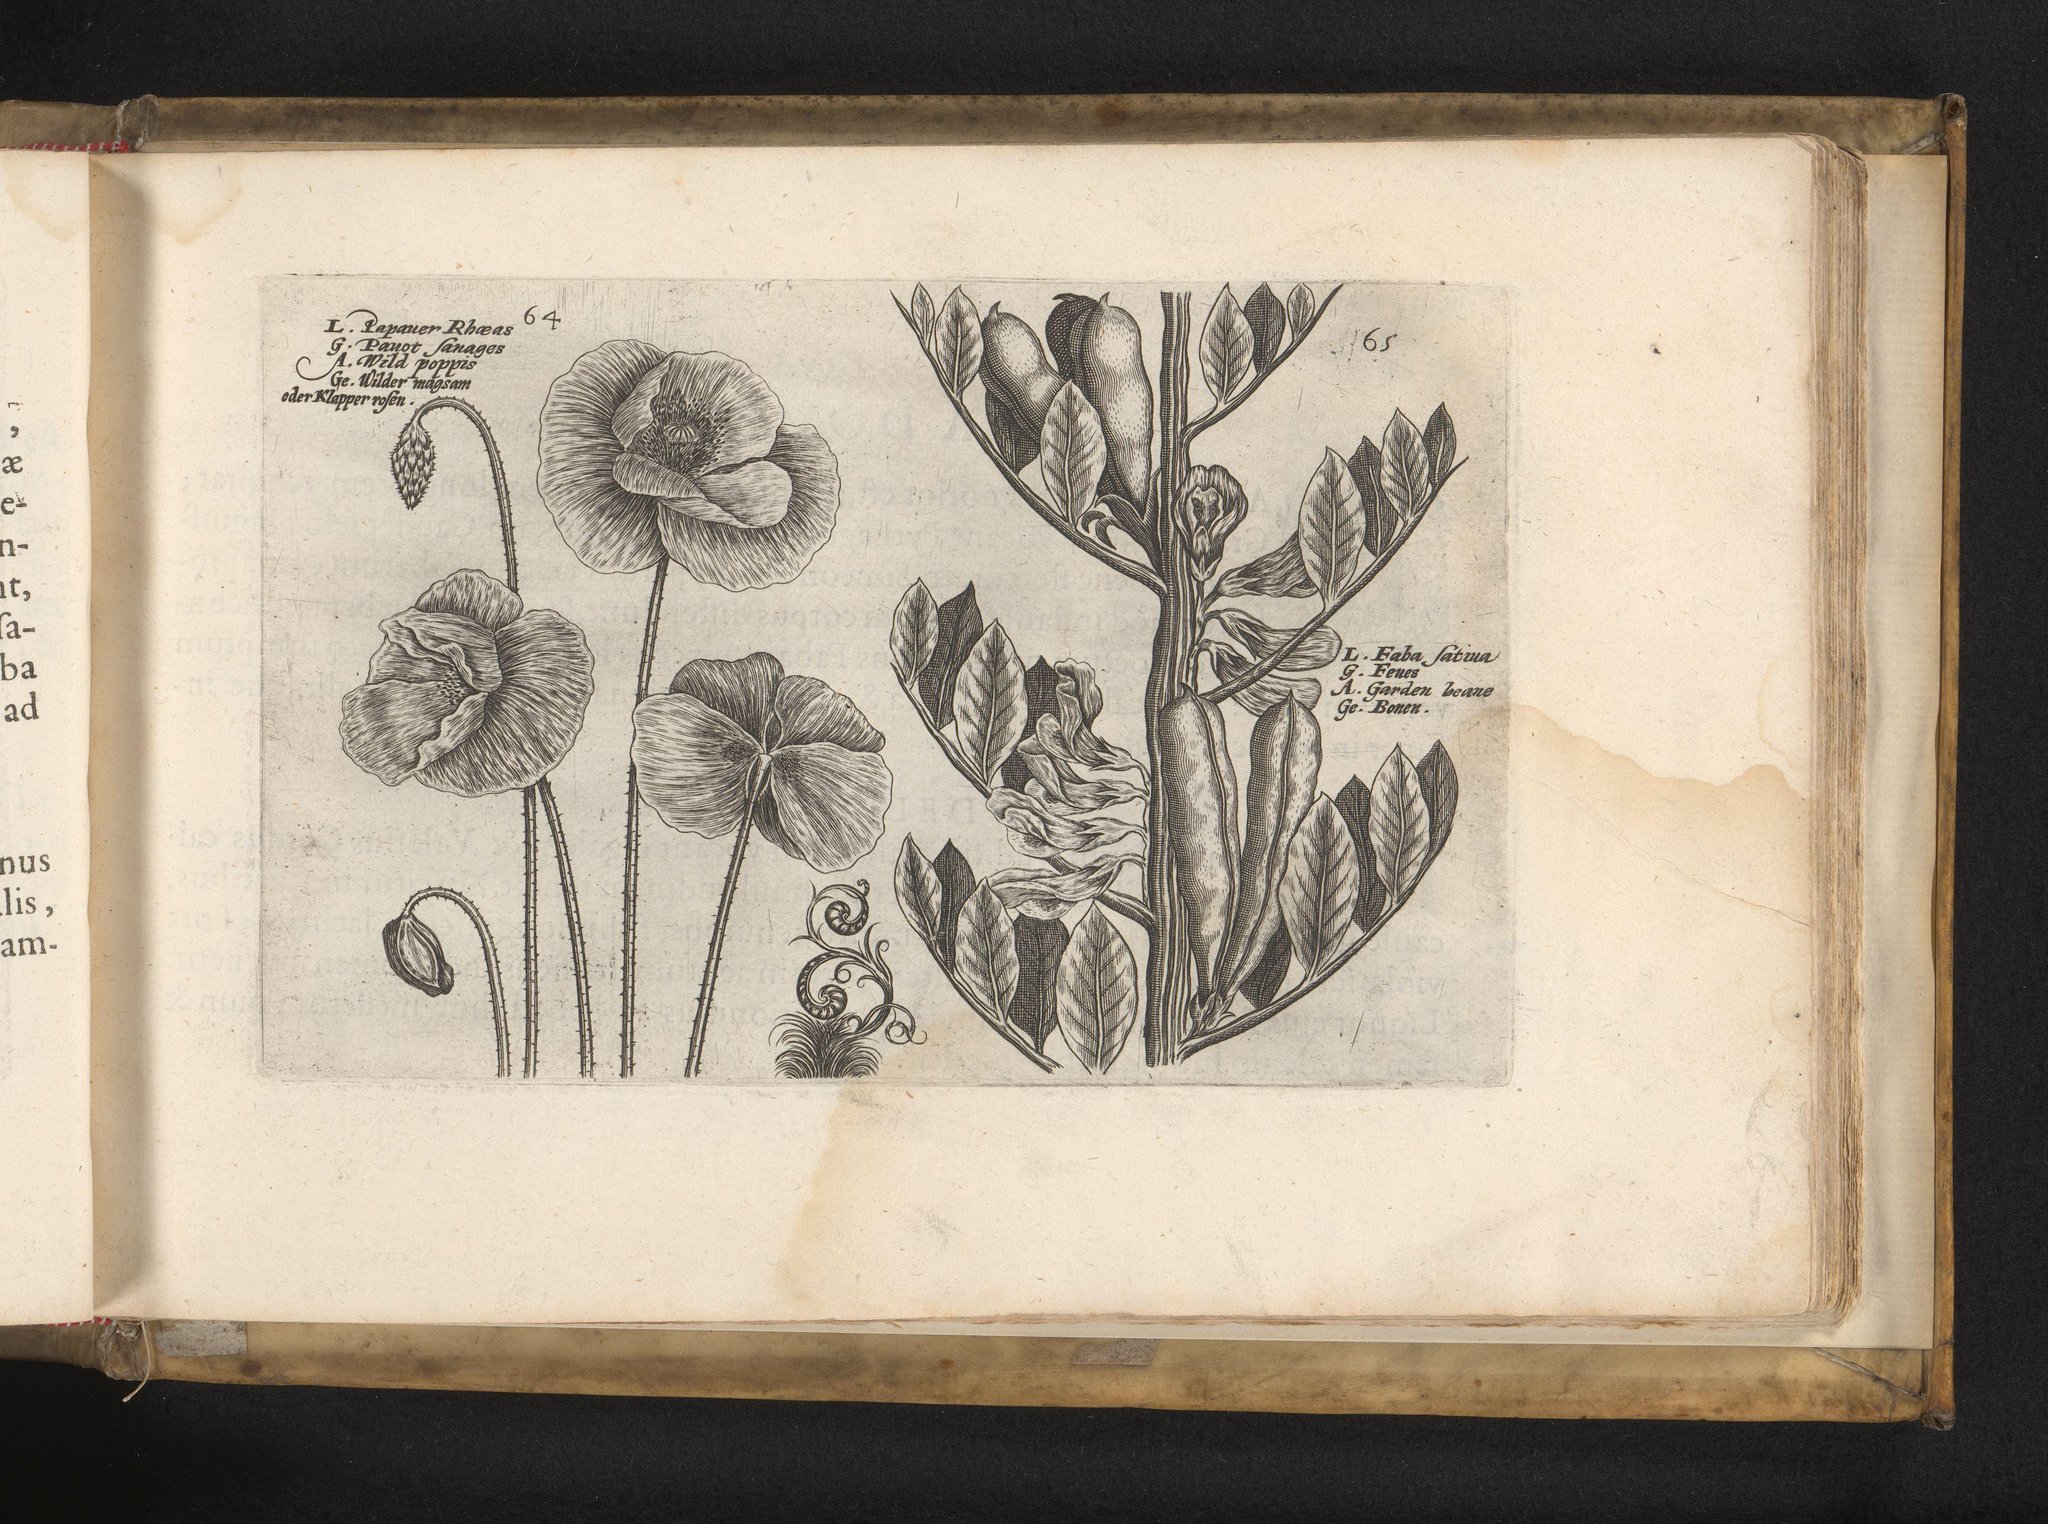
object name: book illustration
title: Bloementuin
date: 1617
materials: paper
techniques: engraving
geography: arnhem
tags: flowers, vegetables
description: Prent uit: Passe, Crispijn van de (II). Hortus floridus in quo rariorum & minus vulgarium florum icones ad vivam veramque formam. Arnhem: Johannes Janssonius, 1617.